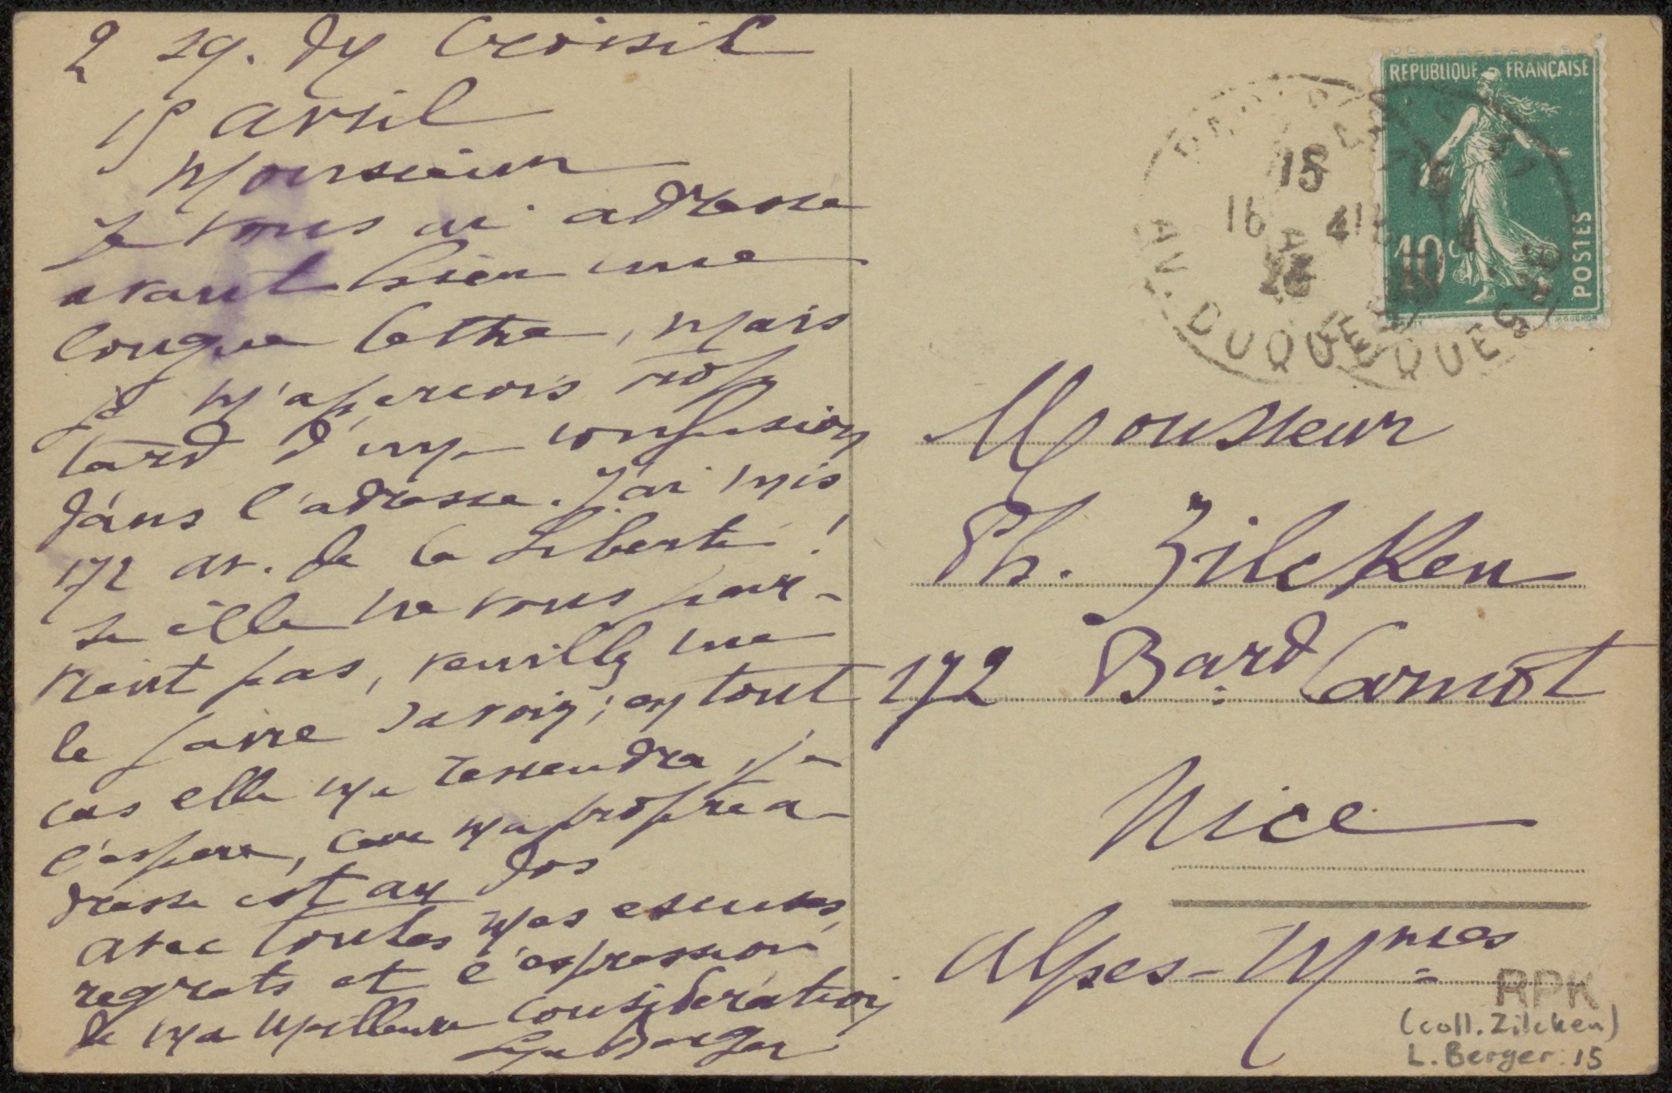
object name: ansichtkaart, prentbriefkaart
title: Prentbriefkaart aan Philip Zilcken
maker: lya berger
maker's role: schrijver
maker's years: 1877-1941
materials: cardboard, ink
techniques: pen, printing, writing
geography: paris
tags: the hague, painter, draughtsman, philip zilcken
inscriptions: collector's mark: ‘RPK’